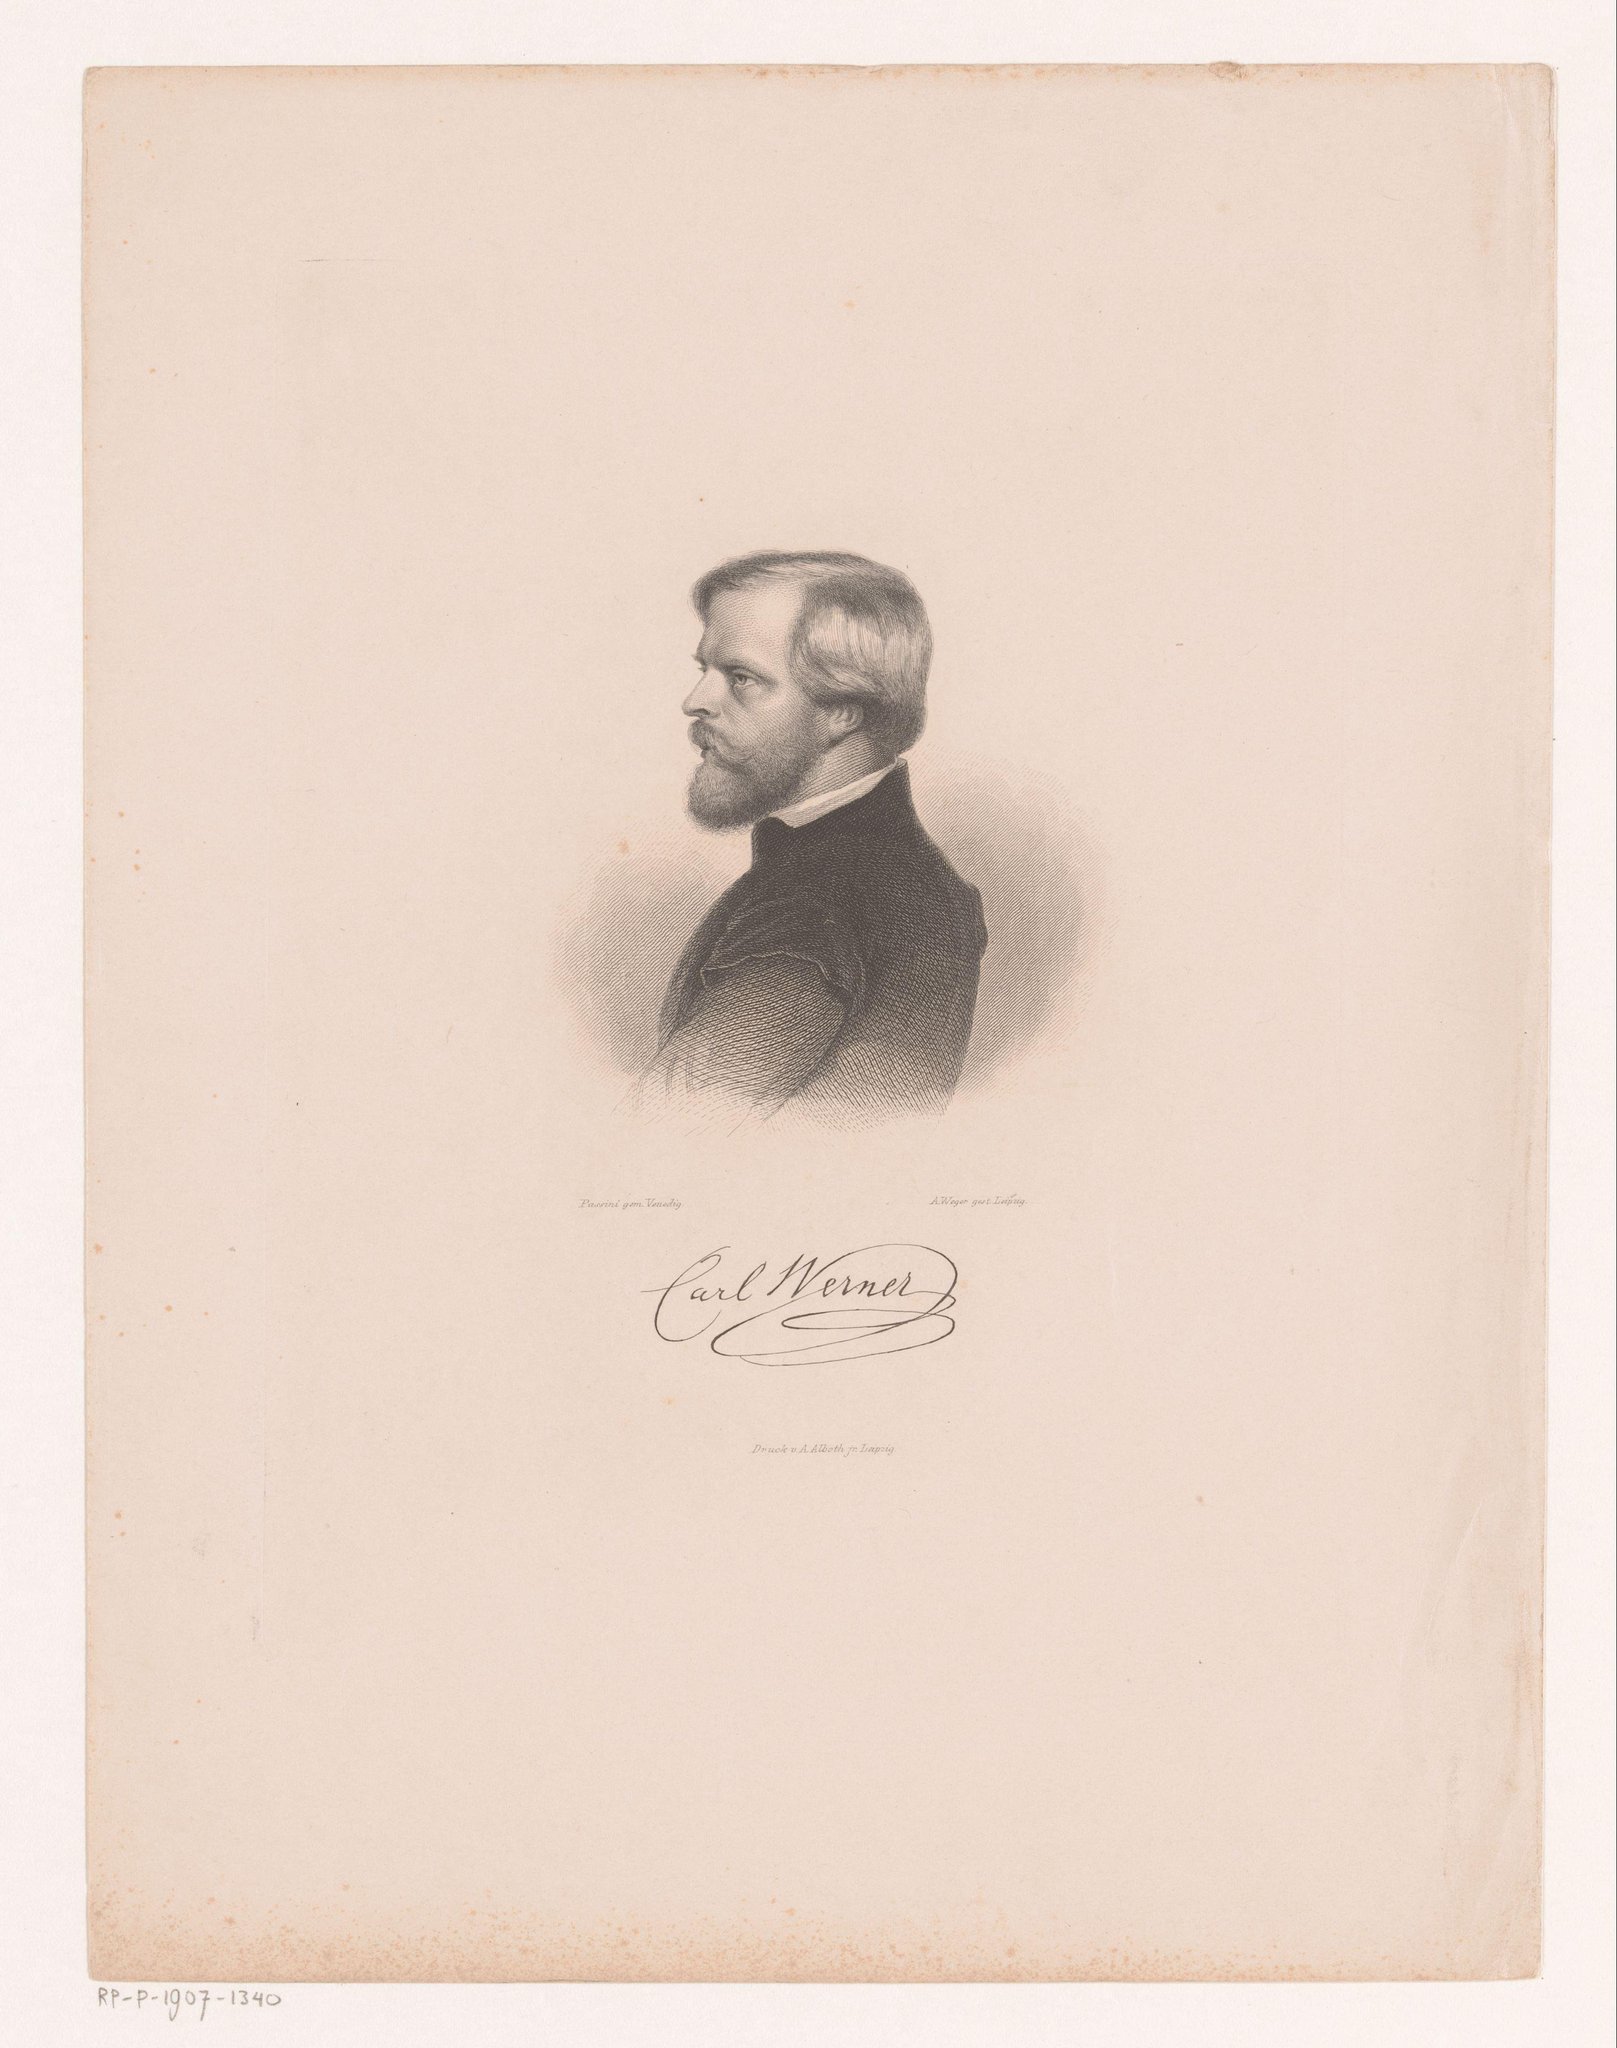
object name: print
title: Portret van Carl Werner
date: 1849-1892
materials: paper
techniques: engraving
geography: leipzig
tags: painter, print maker, carl werner, historical persons, portrait, self-portrait of artist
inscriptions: collector's mark: Lugt 2228